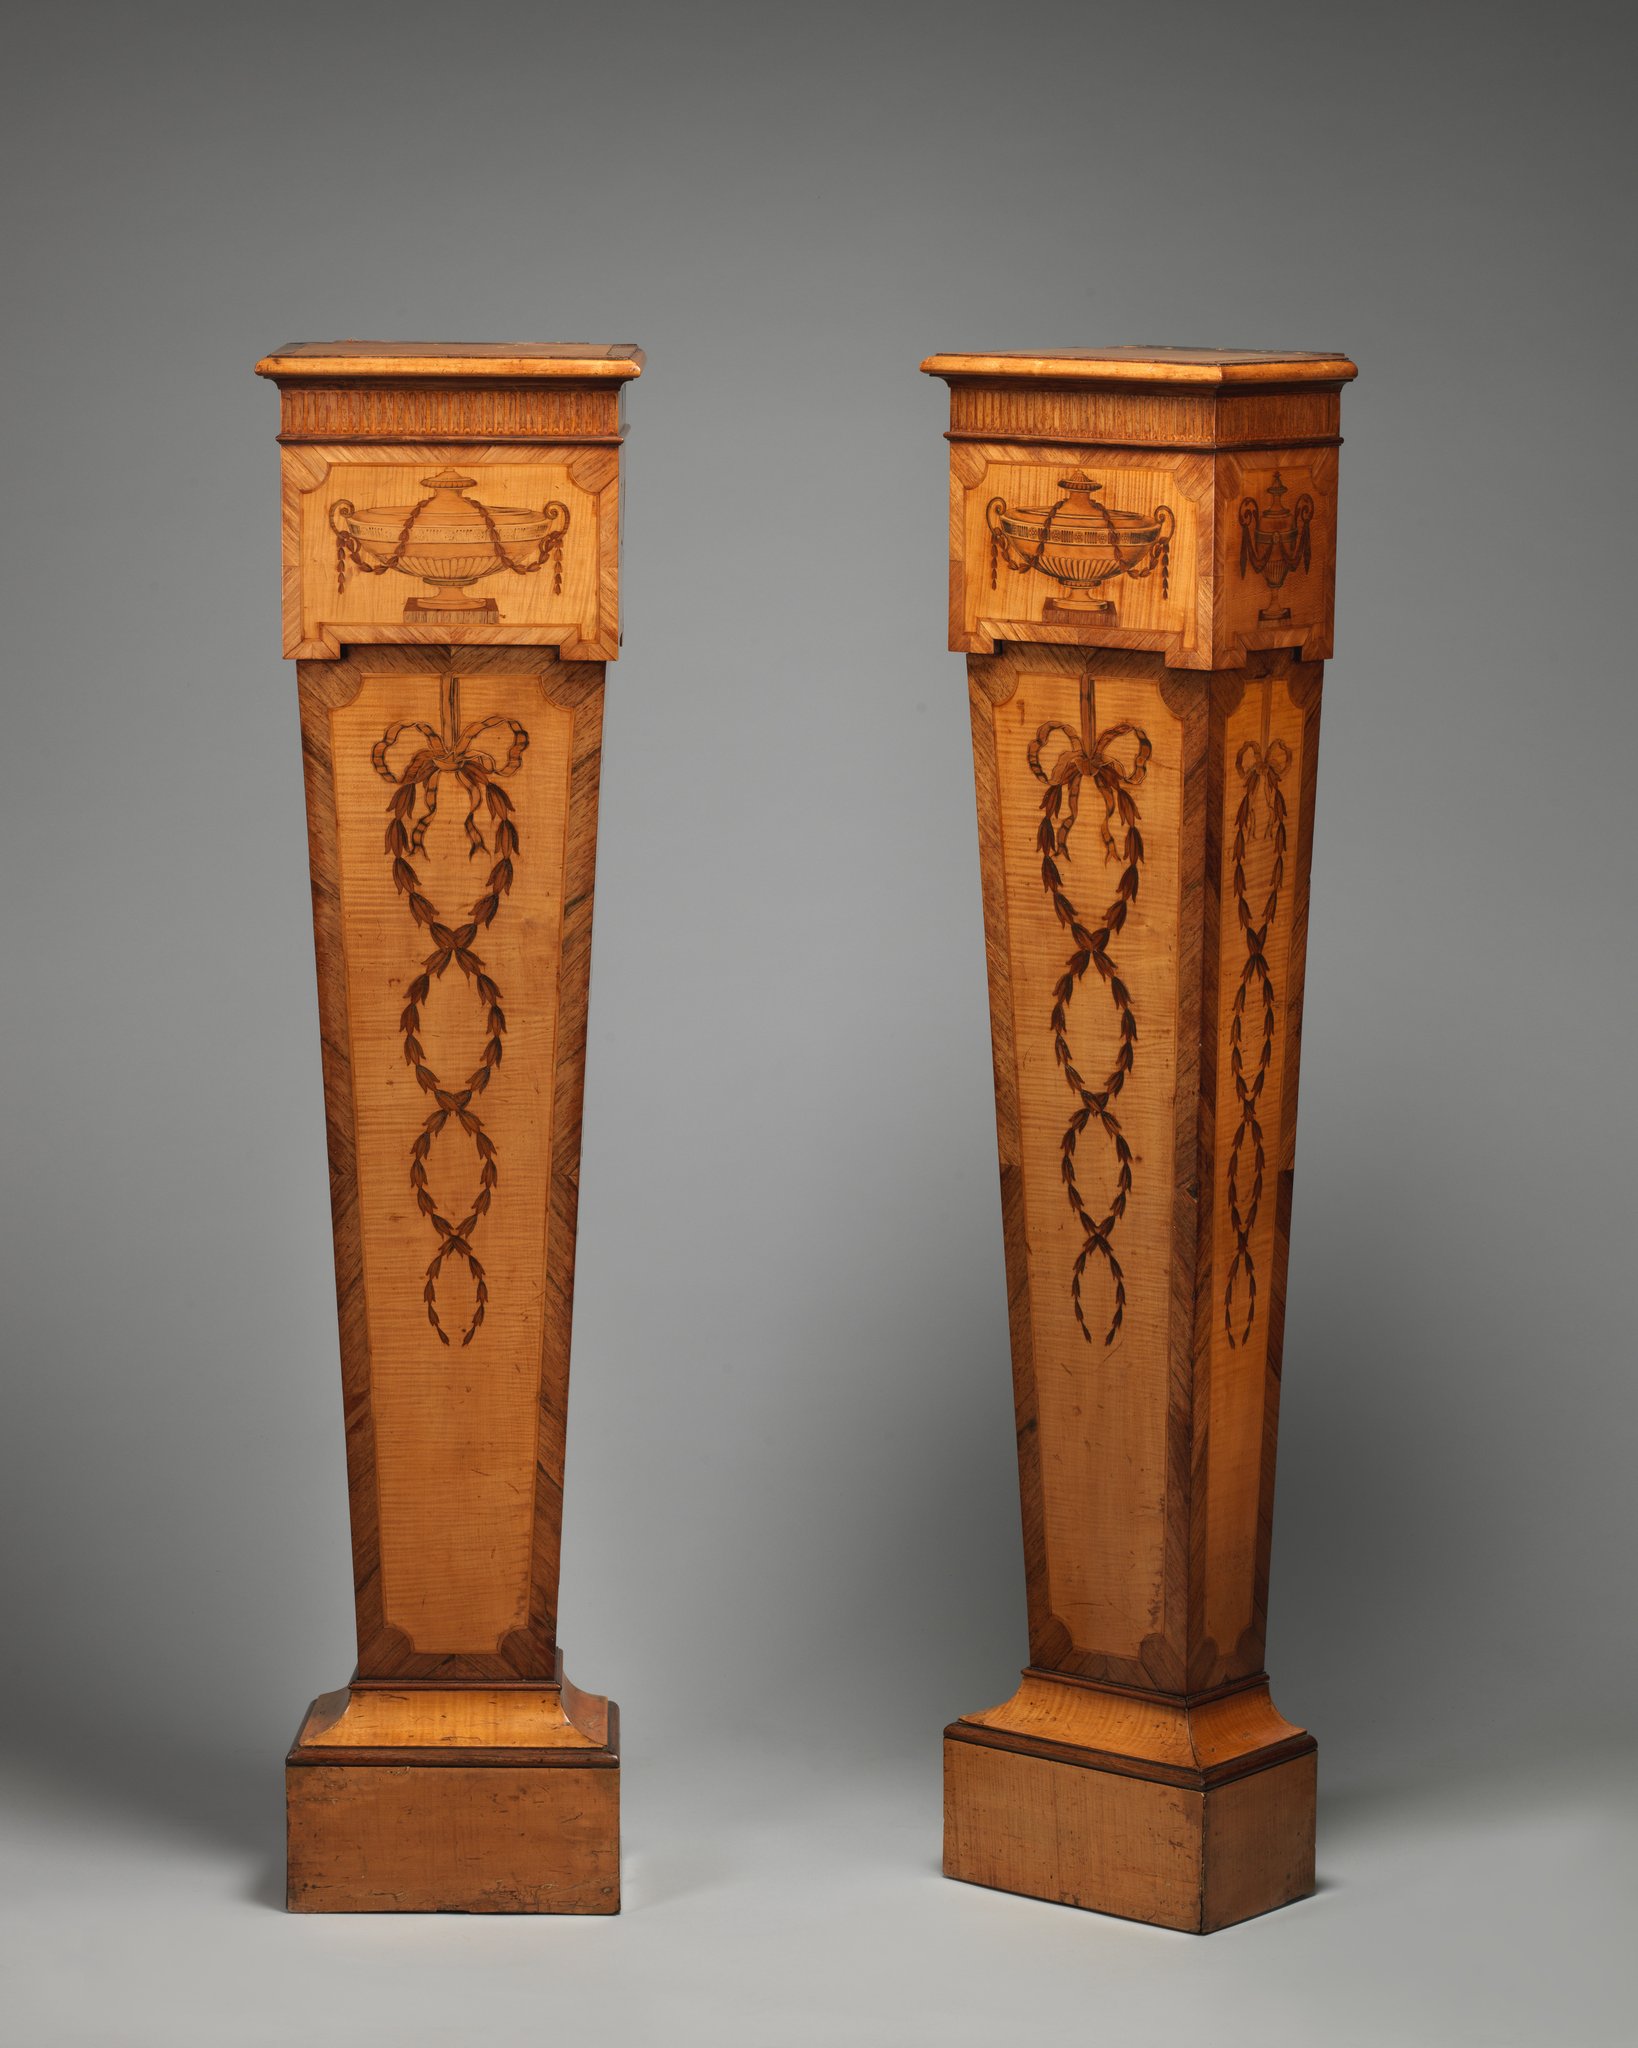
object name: pedestal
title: Pair of pedestals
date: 1778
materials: wood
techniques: inlay, veneering